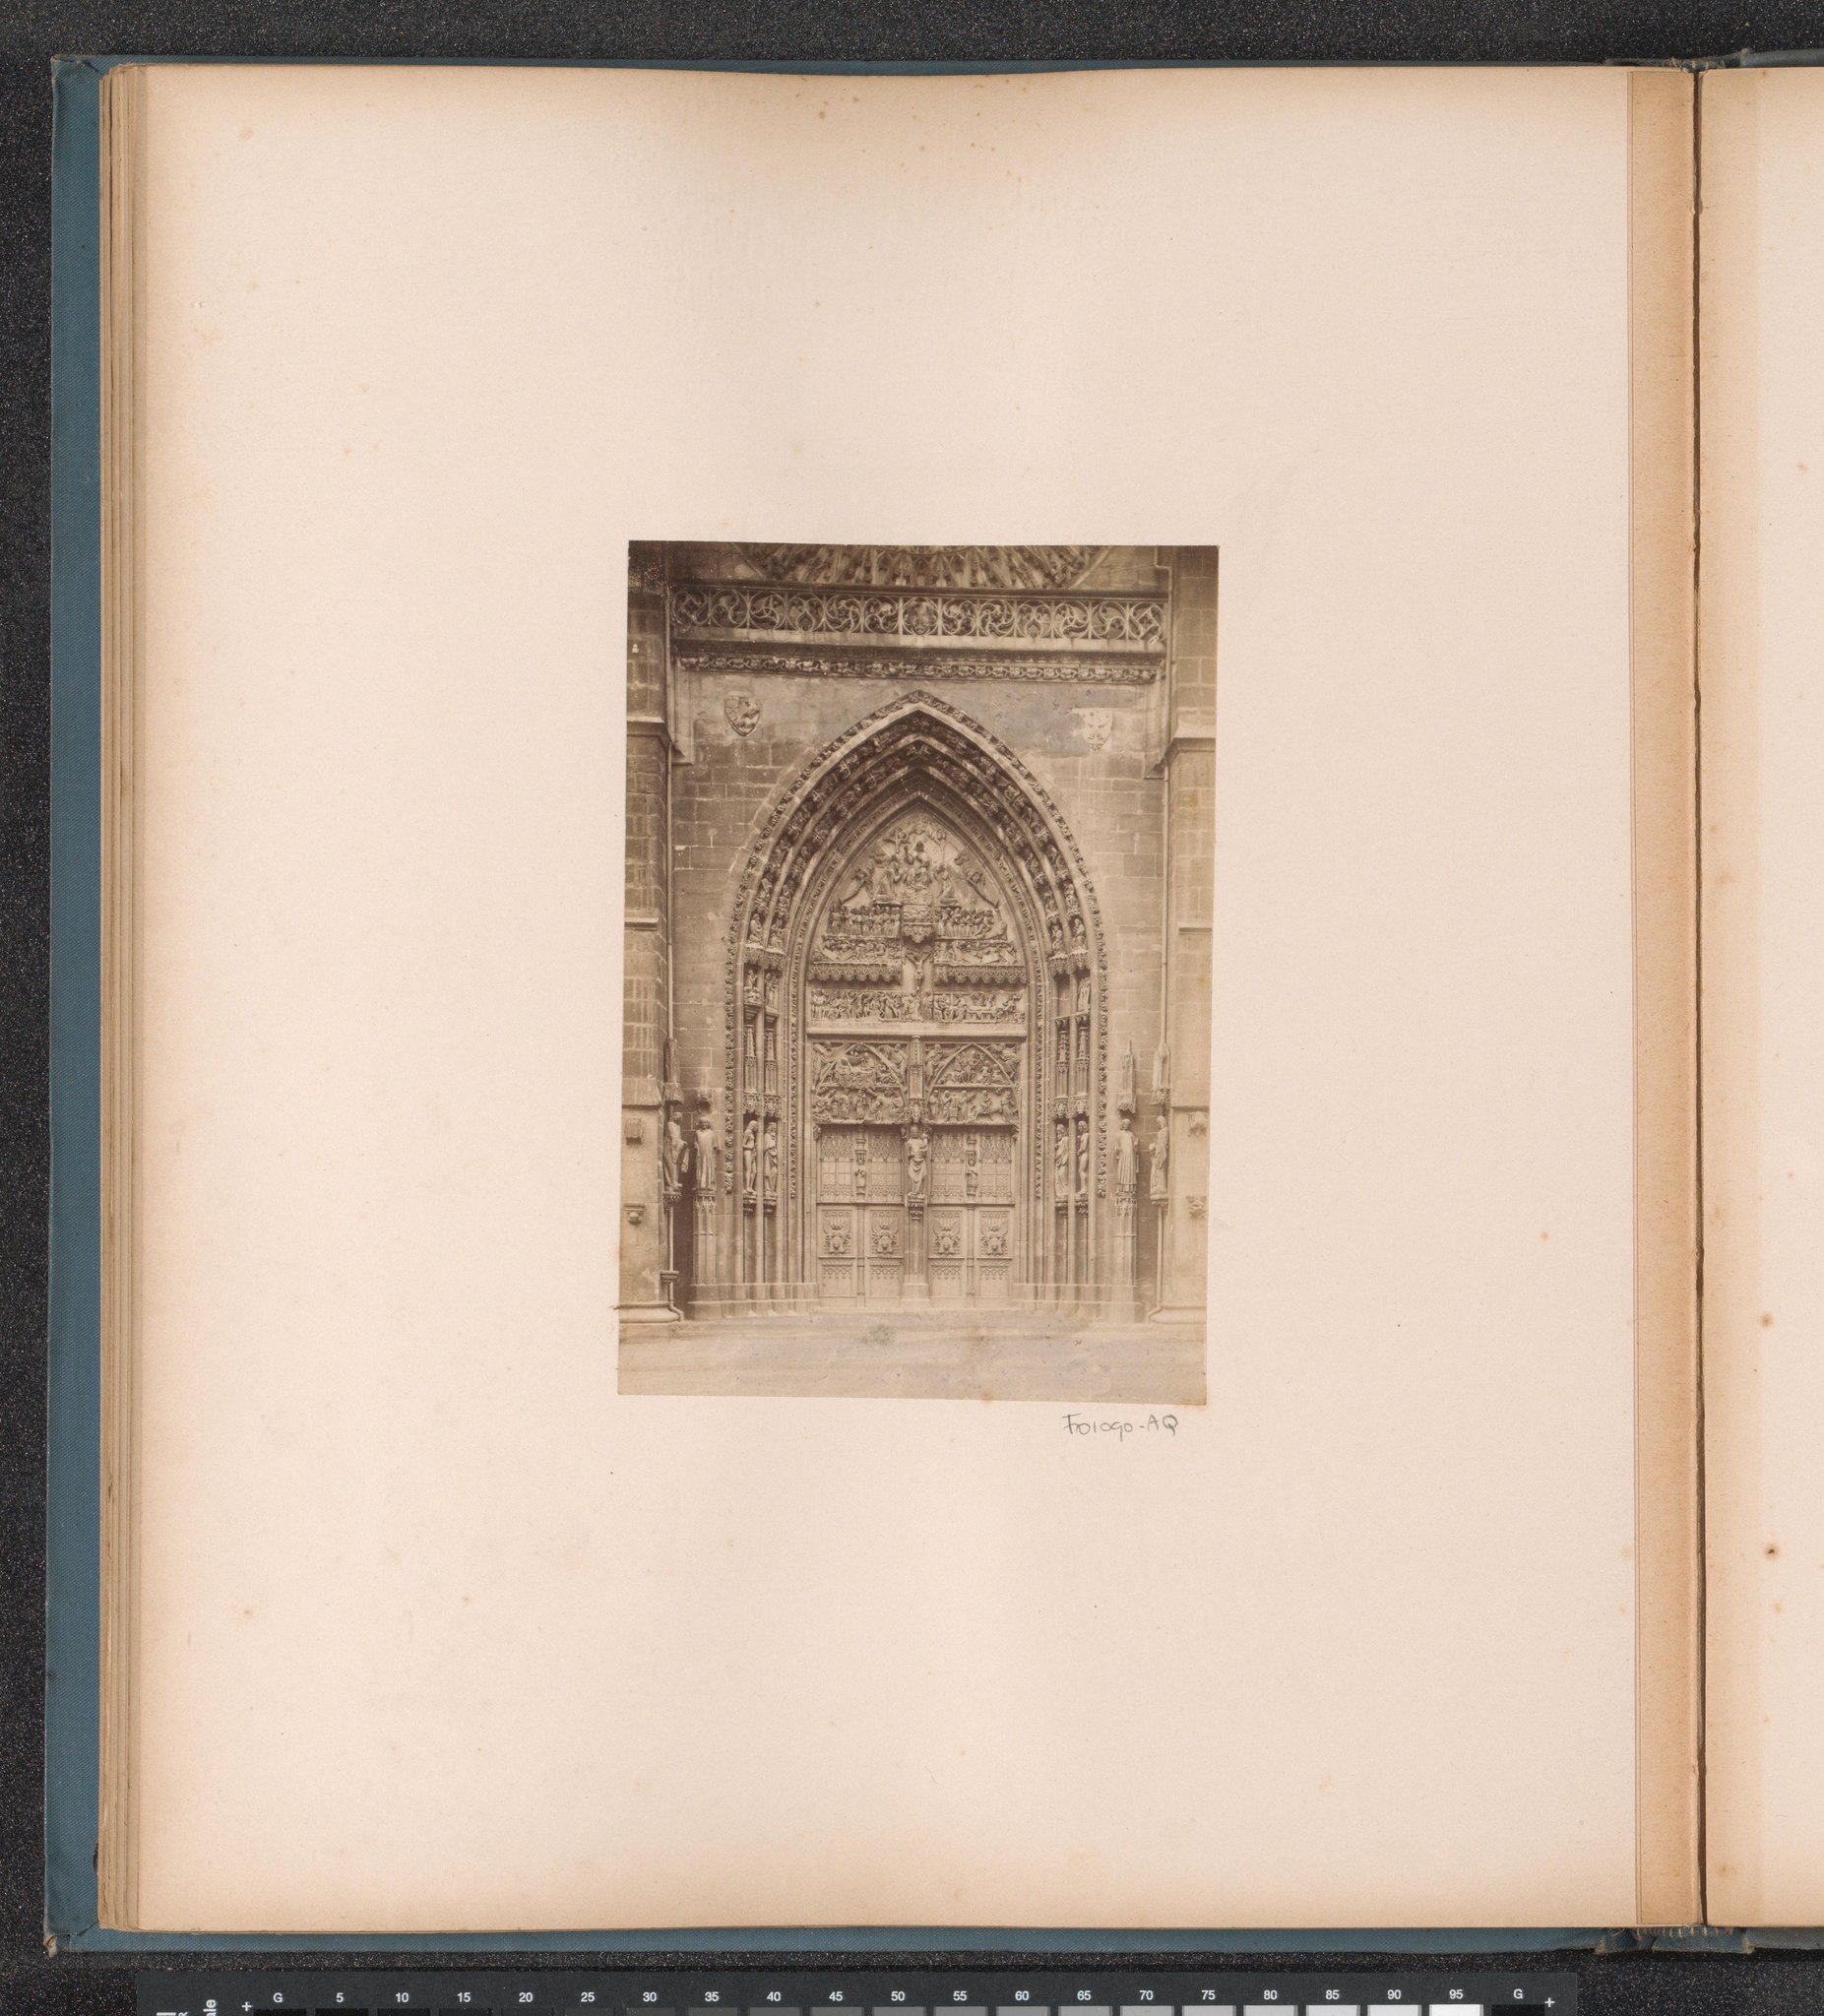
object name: photograph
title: Portaal van de Sint-Laurentiuskerk in Neurenberg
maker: Anonymous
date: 1870-1900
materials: paper, photographic support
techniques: albumen print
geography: nuremberg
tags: parts of church exterior and annexes: portal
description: Onderdeel van Reisalbum met foto's van bezienswaardigheden in Duitsland en Oostenrijk en van kunstwerken.